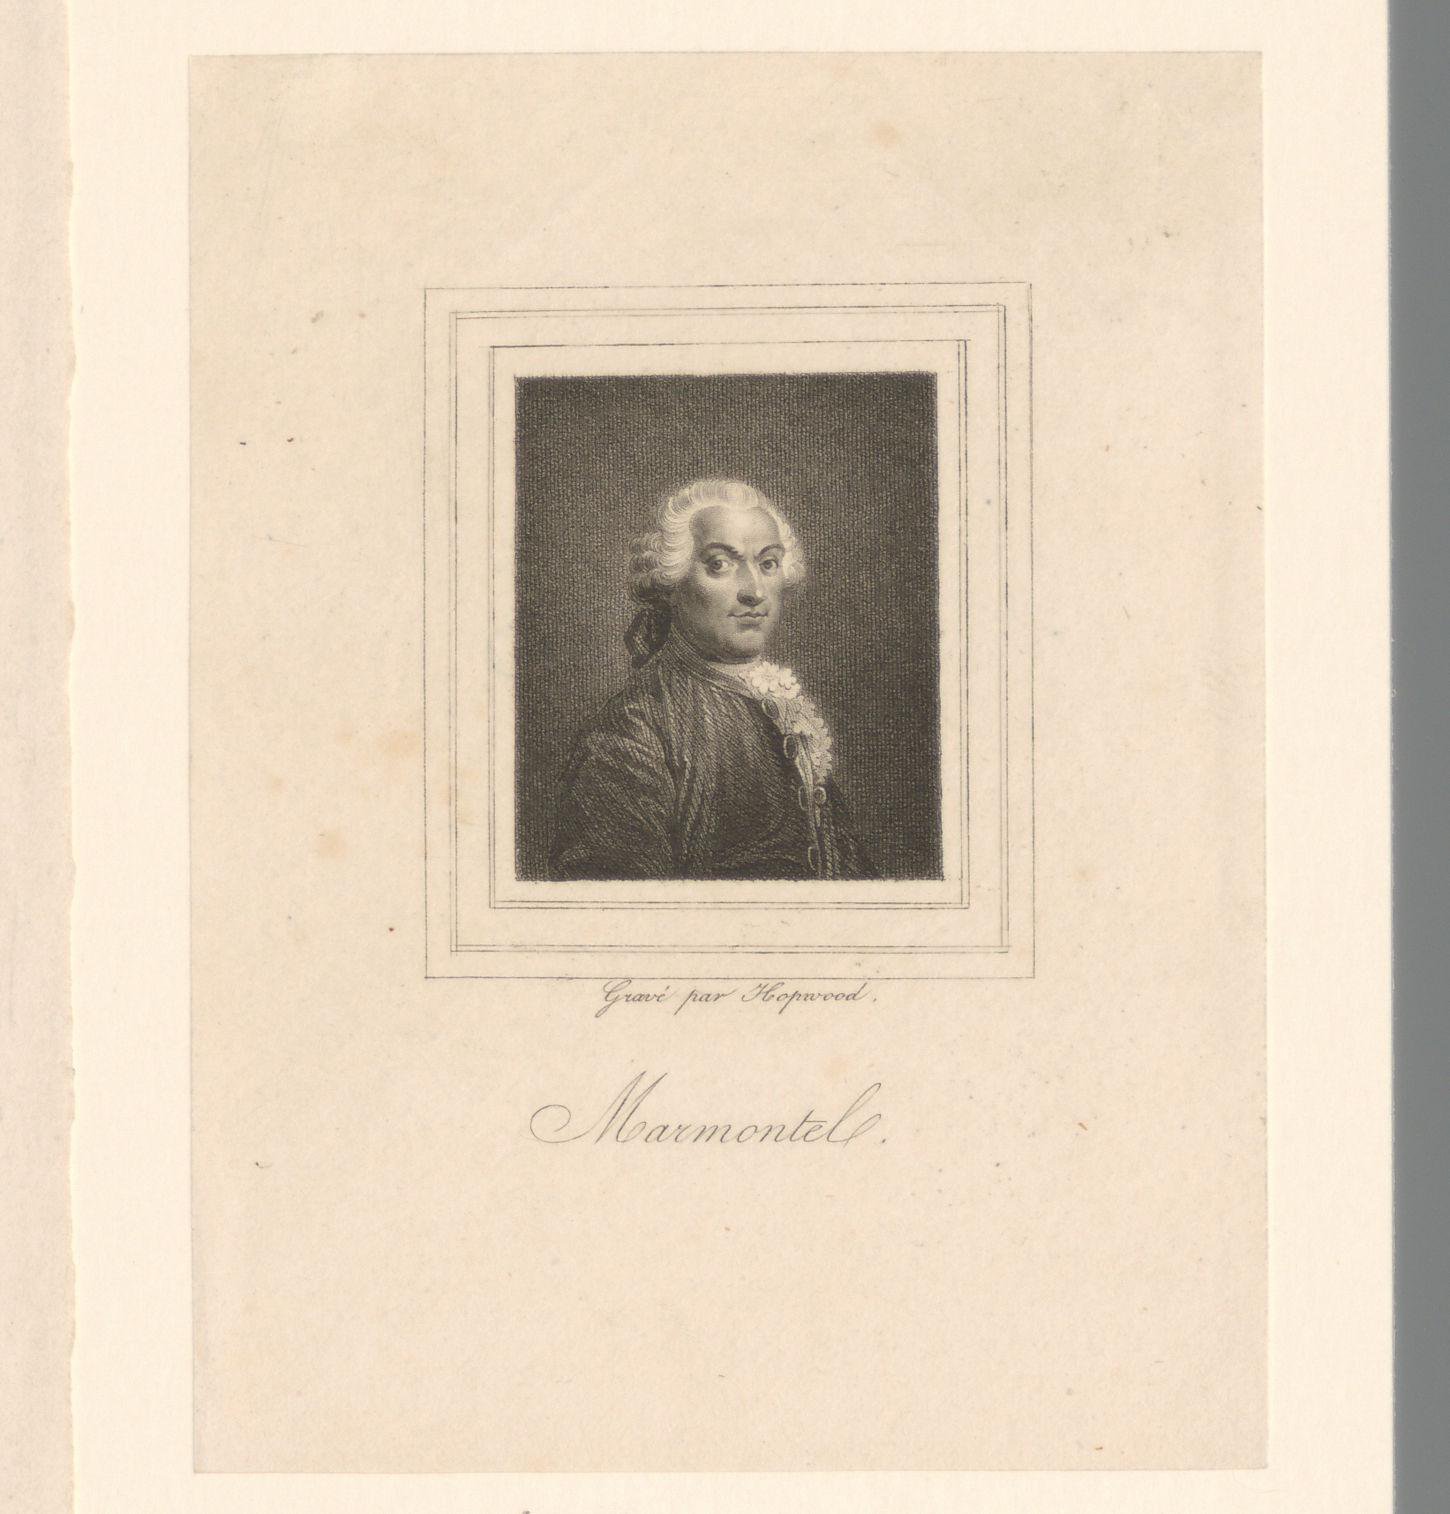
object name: print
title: Portret van Jean-François Marmontel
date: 1828-1850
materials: paper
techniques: etching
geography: paris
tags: jean françois marmontel, historical persons, portrait of a writer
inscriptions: collector's mark: Lugt 2228